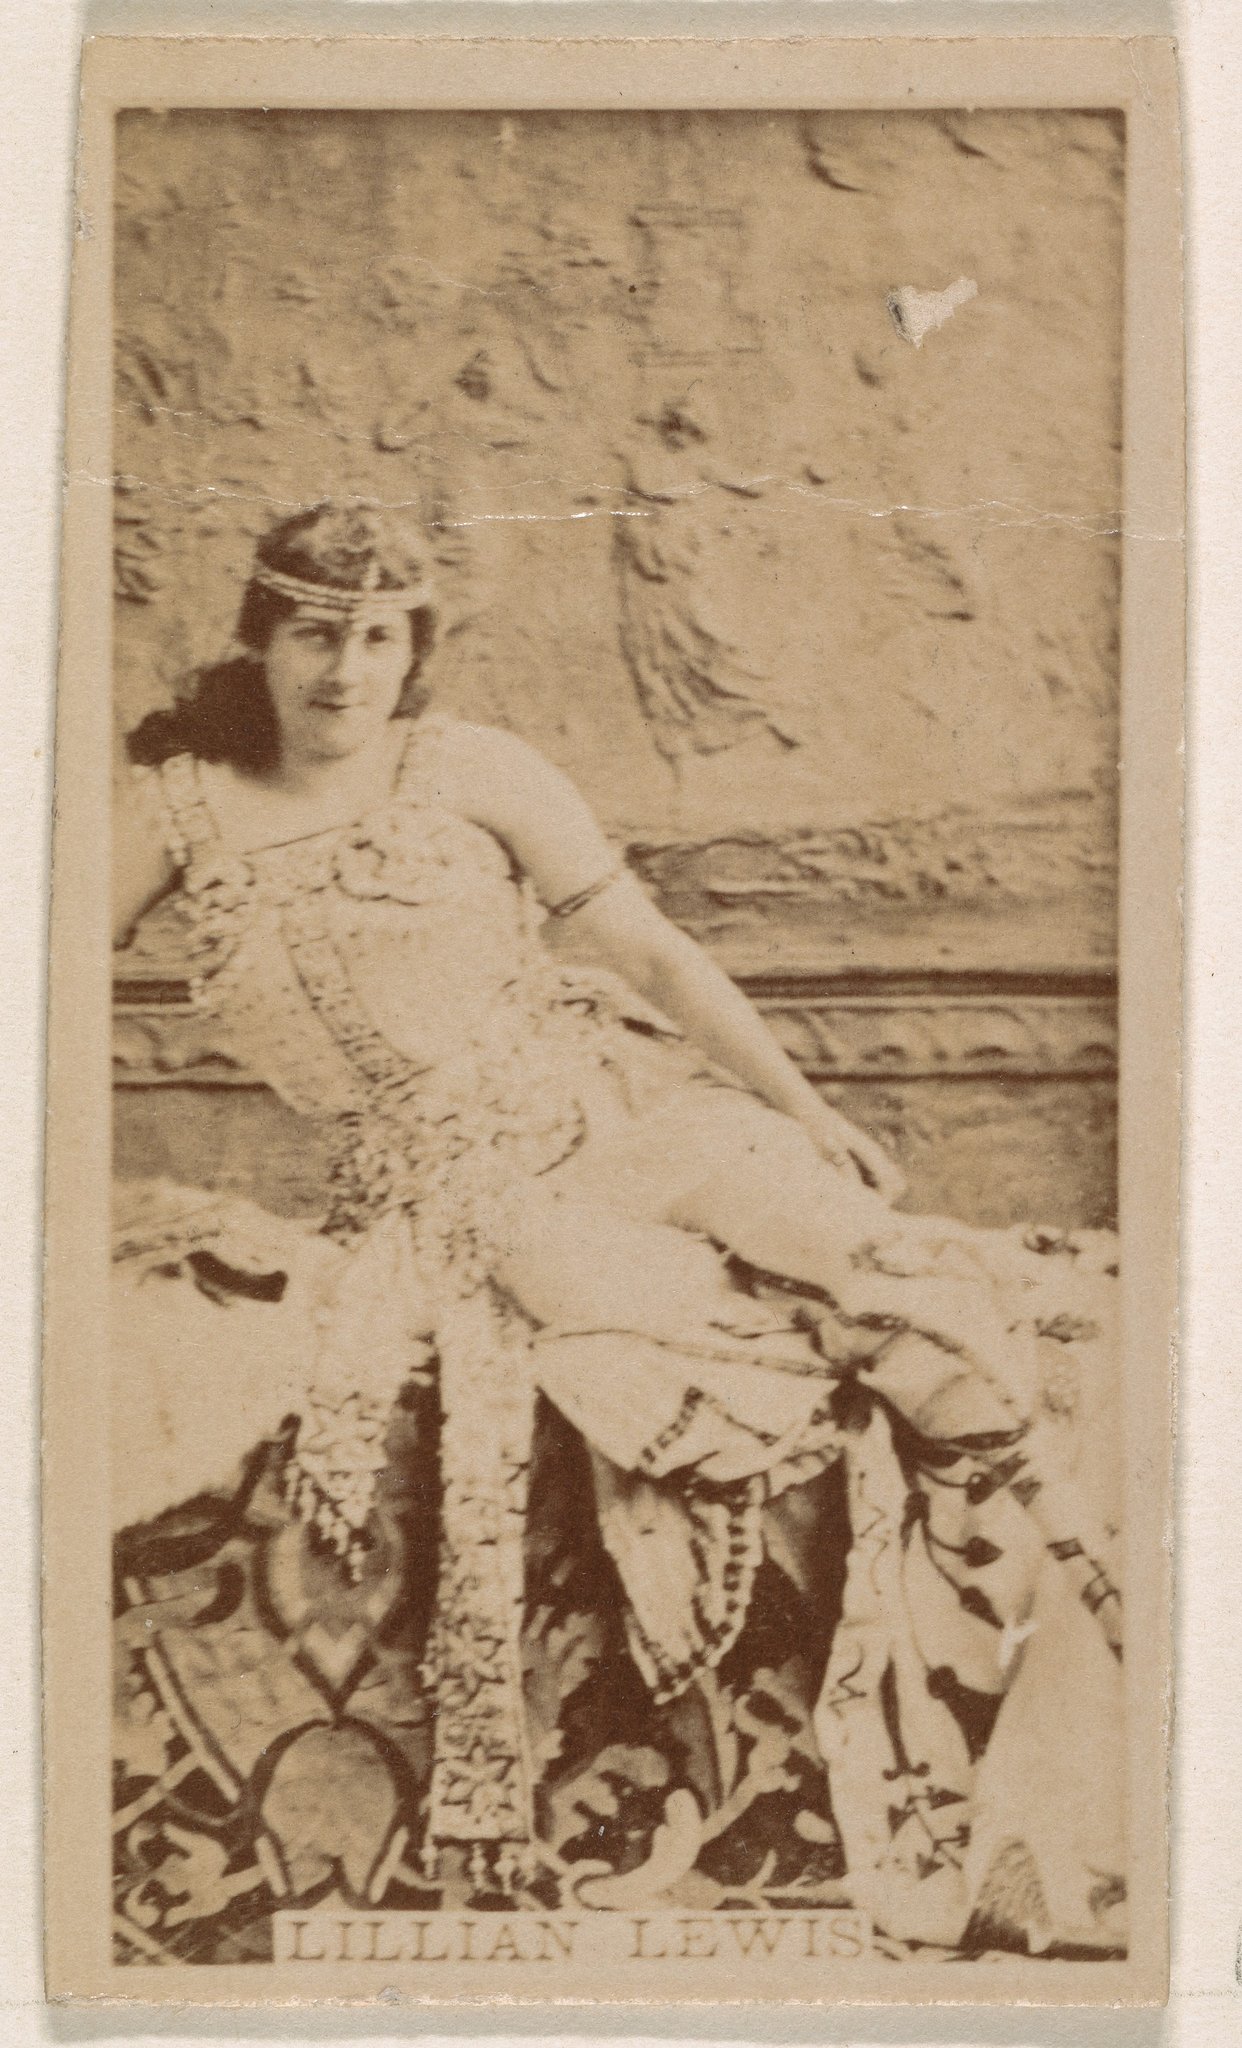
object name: photograph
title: Lillian Lewis, from the Actresses series (N245) issued by Kinney Brothers to promote Sweet Caporal Cigarettes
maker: kinney brothers tobacco company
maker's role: publisher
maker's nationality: american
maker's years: 1869-2011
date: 1890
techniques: albumen silver print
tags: portraits,women,actresses